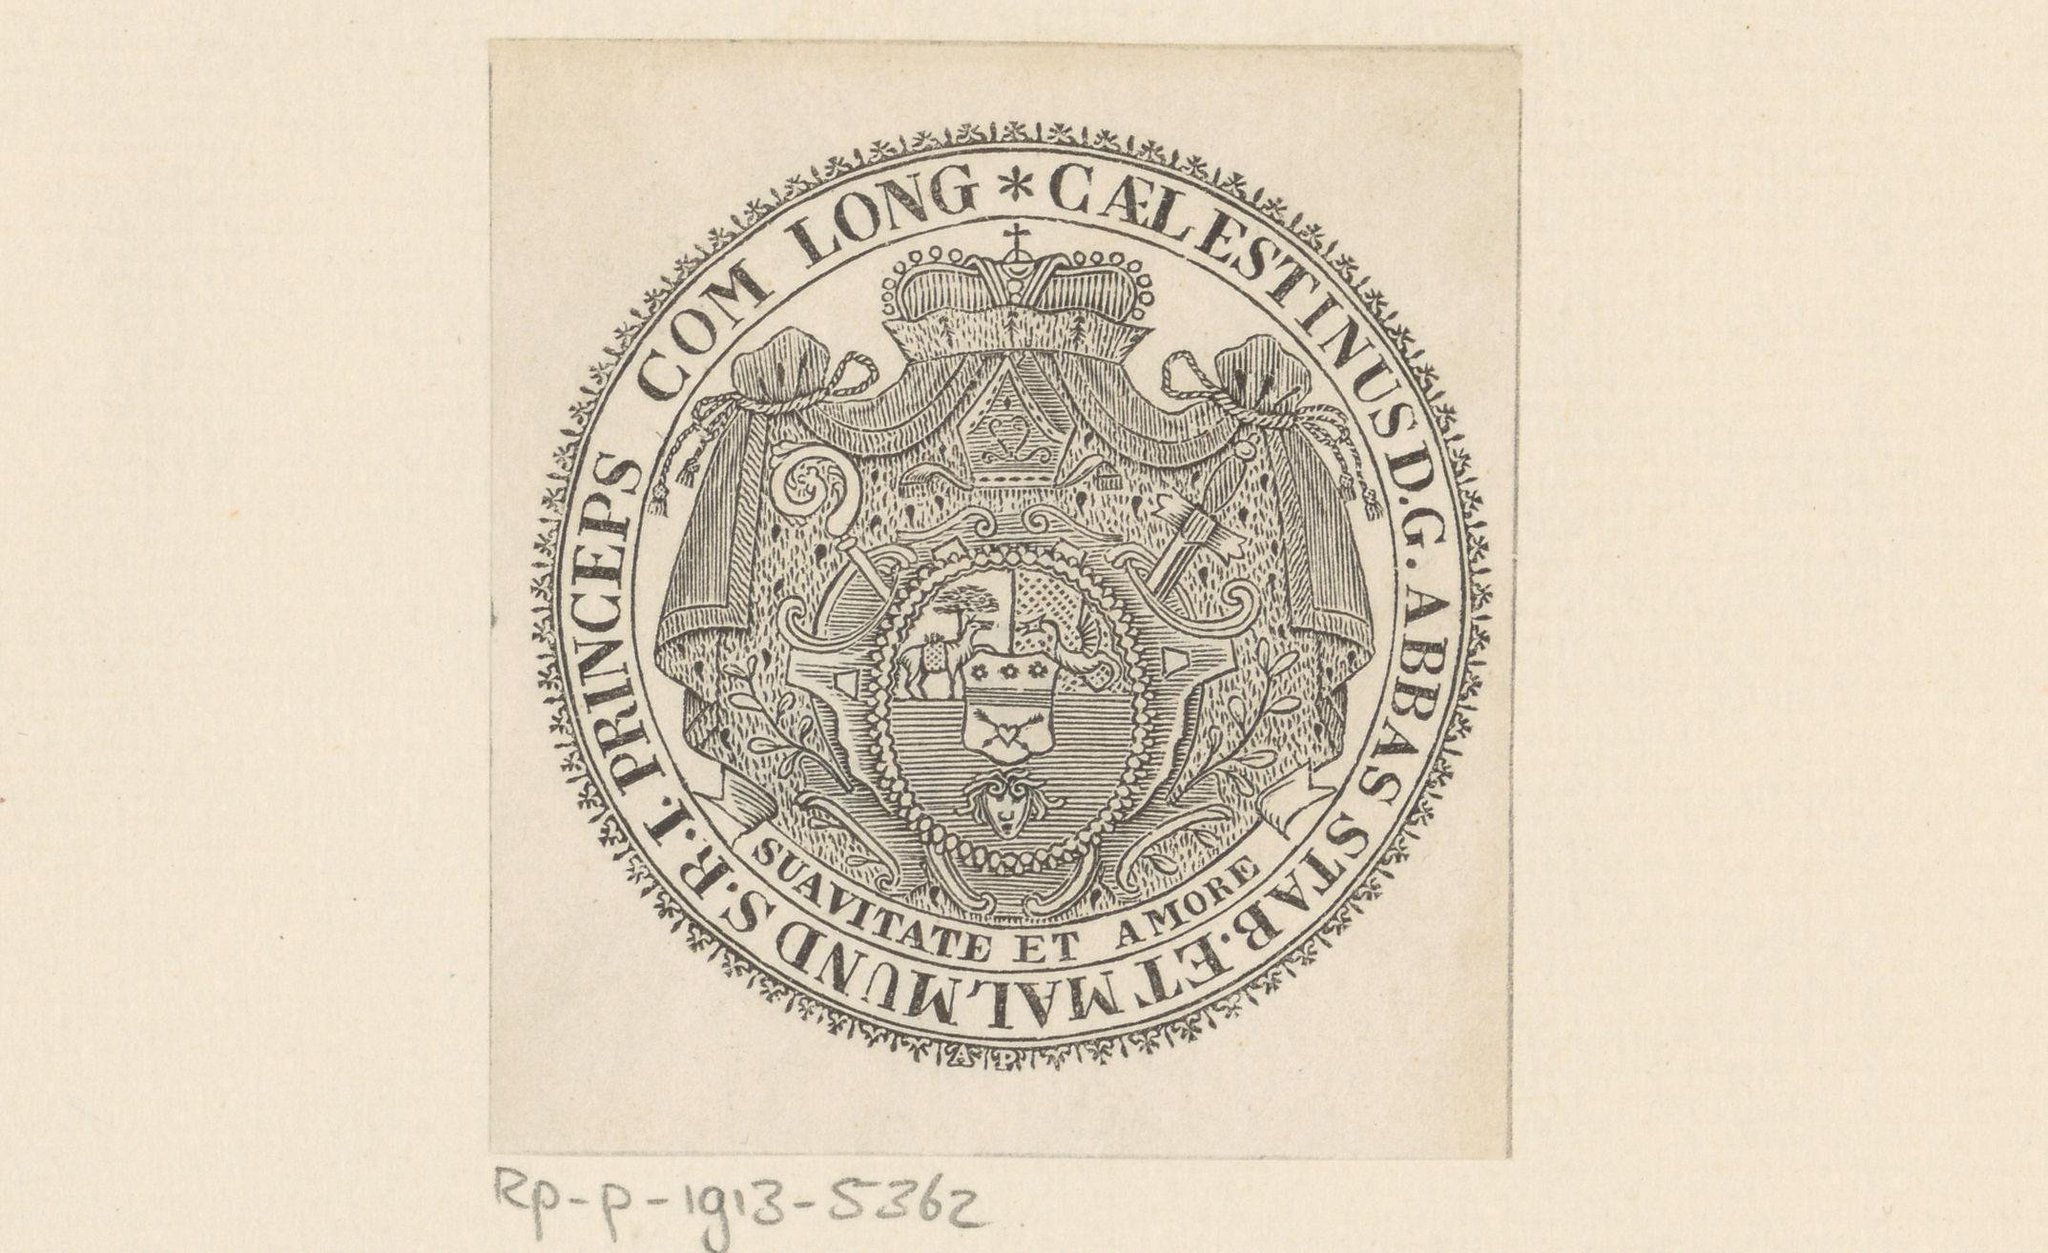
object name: bookplate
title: Suavitate et amore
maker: Anonymous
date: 1850-1899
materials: paper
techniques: printing block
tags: armorial bearing, heraldry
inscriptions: collector's mark: Lugt 2760, collector's mark: Lugt 2233